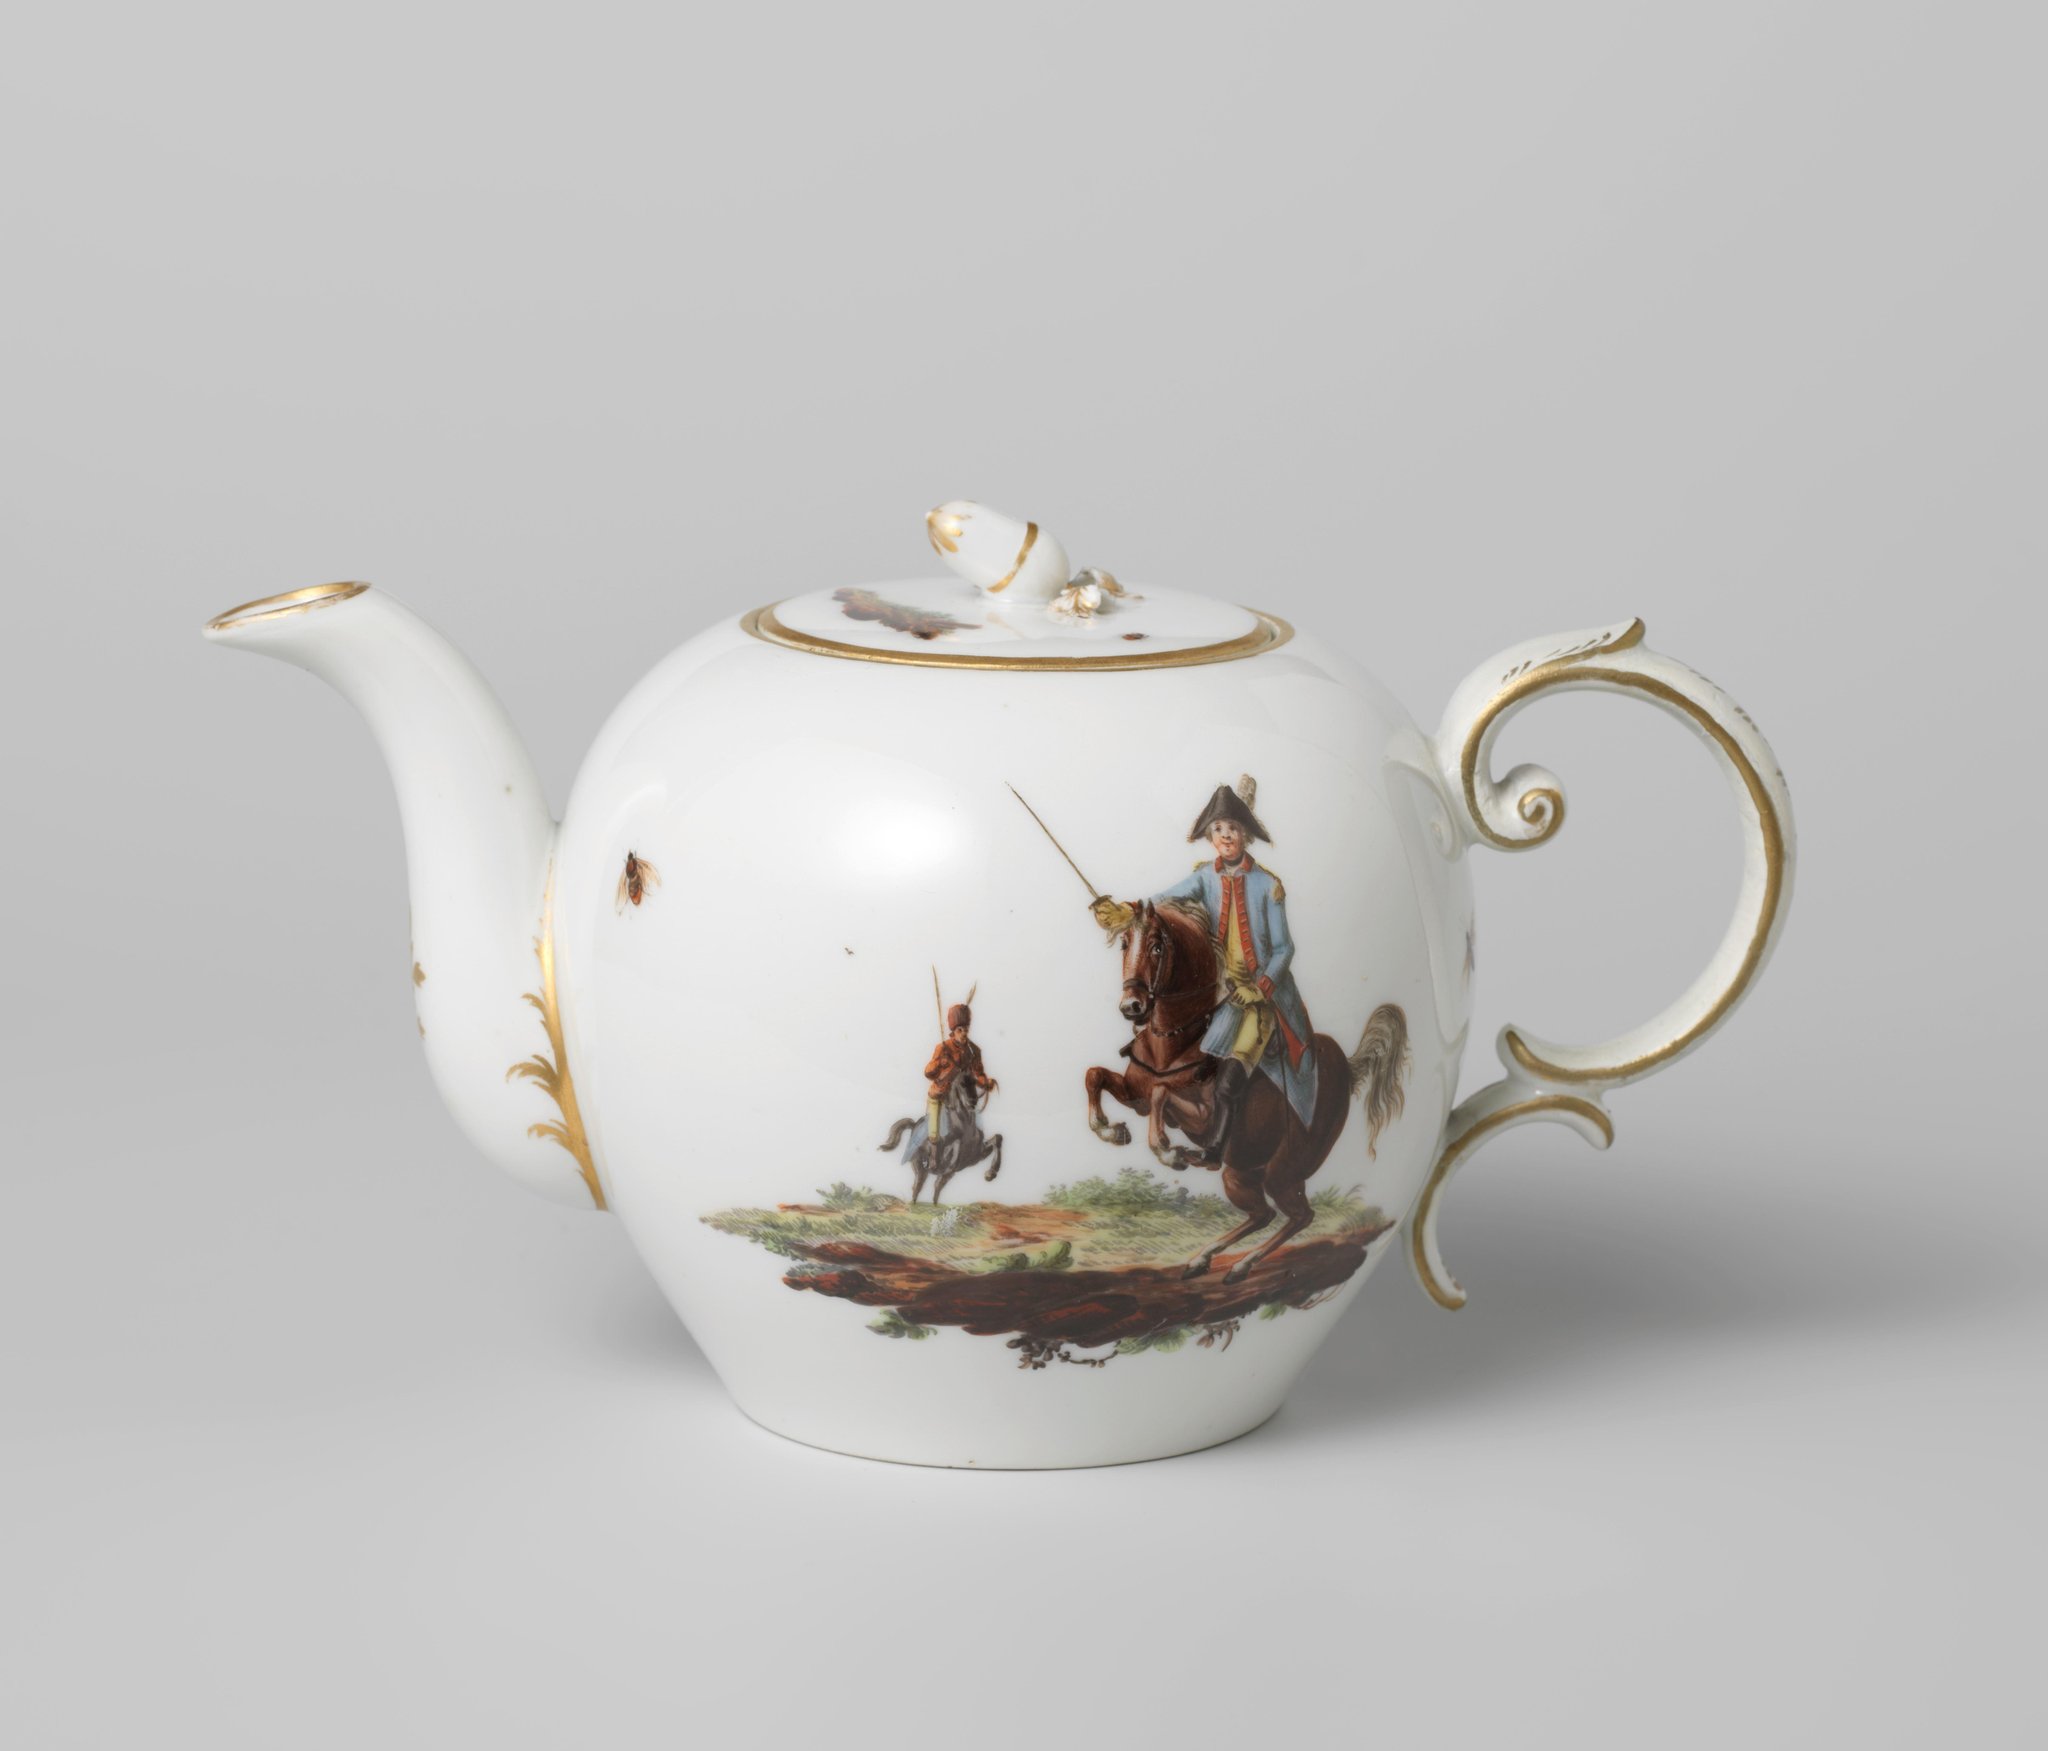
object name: teapot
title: Theepot, beschilderd met cavaleristen. Langs tuit en oor insekten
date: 1784-1809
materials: porcelain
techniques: painted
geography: ouder-amstel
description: Theepot veelkleurig beschilderd met cavaleristen. Langs de tuit en het oor insecten. Gemerkt: Amstel in onderglazuurblauw en ingegrift *L.1.